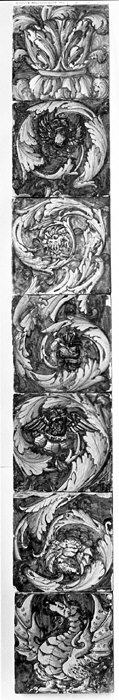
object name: tile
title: Set of seven tiles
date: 1600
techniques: maiolica, glazing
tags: dragons